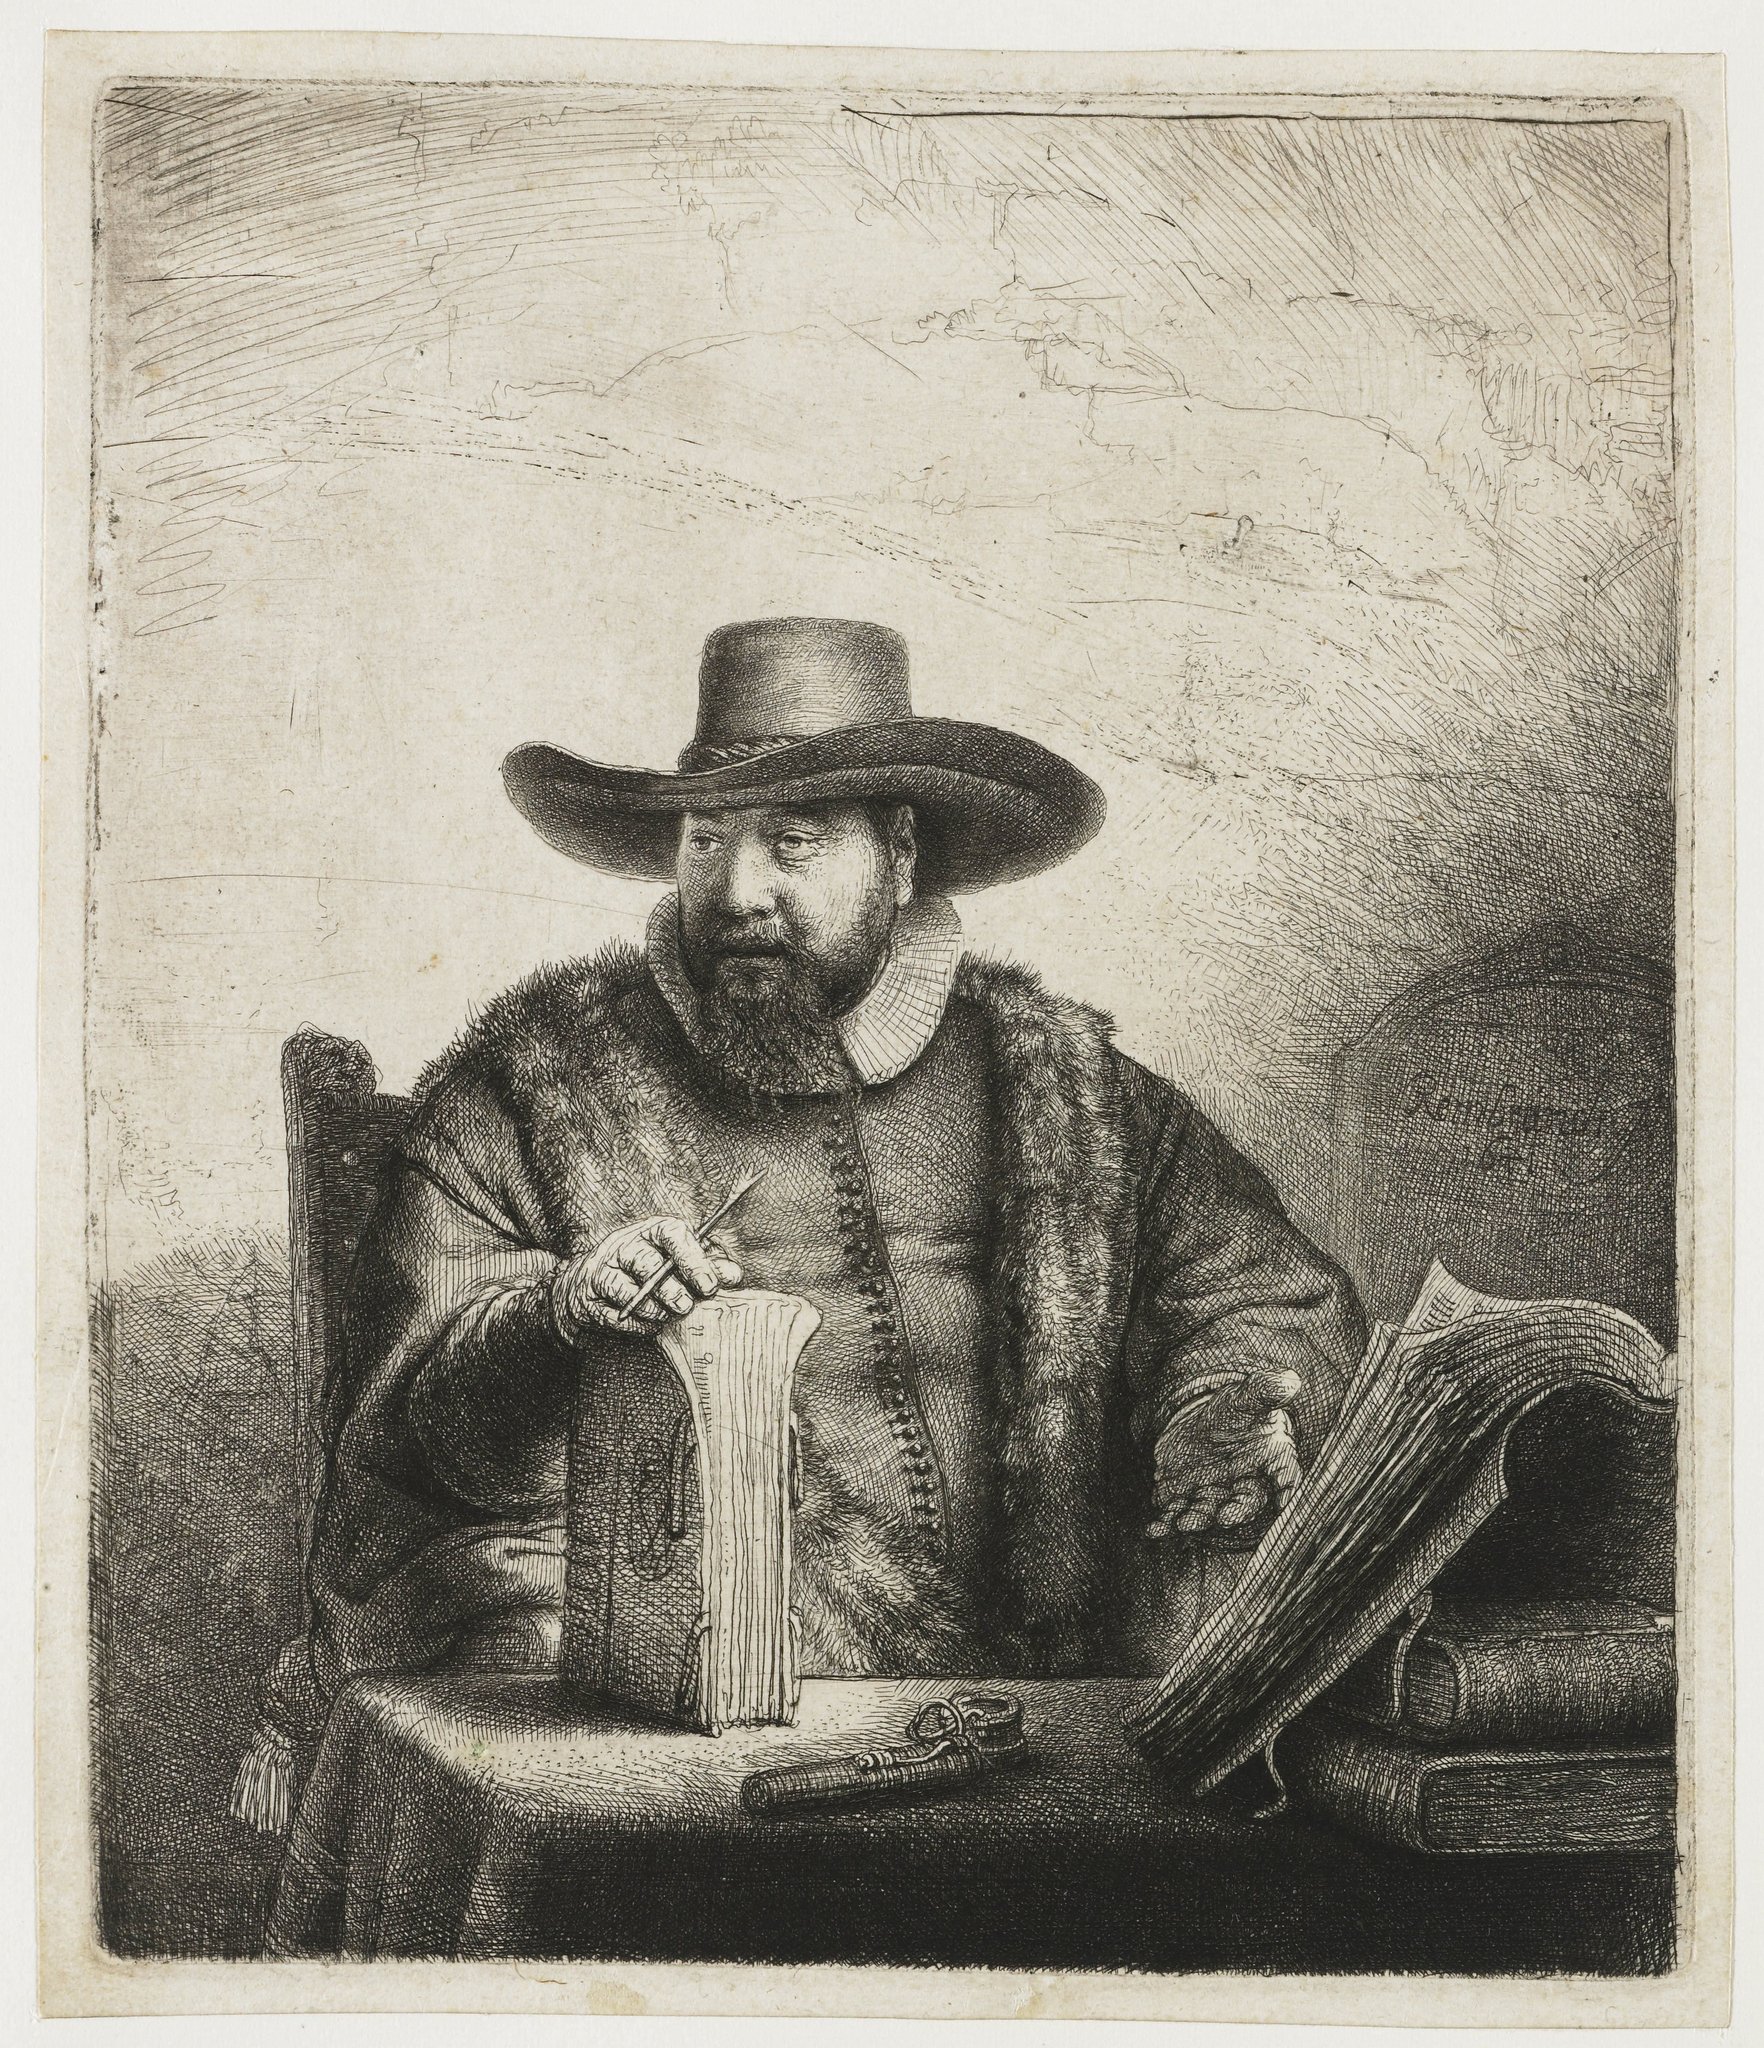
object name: print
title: Cornelis Claesz. Anslo, preacher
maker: rembrandt van rijn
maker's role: draughtsman, painter, print maker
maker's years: 1606-1669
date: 1641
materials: paper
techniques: drypoint, etching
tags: cornelis claesz. anslo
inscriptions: mark: Lugt 926, signature and date: ‘Rembrandt f 1641’, mark: Lugt 119, mark: Lugt 2228, mark: Lugt 272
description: Cornelis Anslo was a cloth merchant and preacher in Amsterdam. Rembrandt may have met him through Saskia’s cousin, Hendrick Uylenburgh, who was a member of Anslo’s congregation. Here he gestures with his left hand, as though speaking, which naturally refers to his function as a pastor. Rembrandt detailed his hat and clothing with utmost precision.